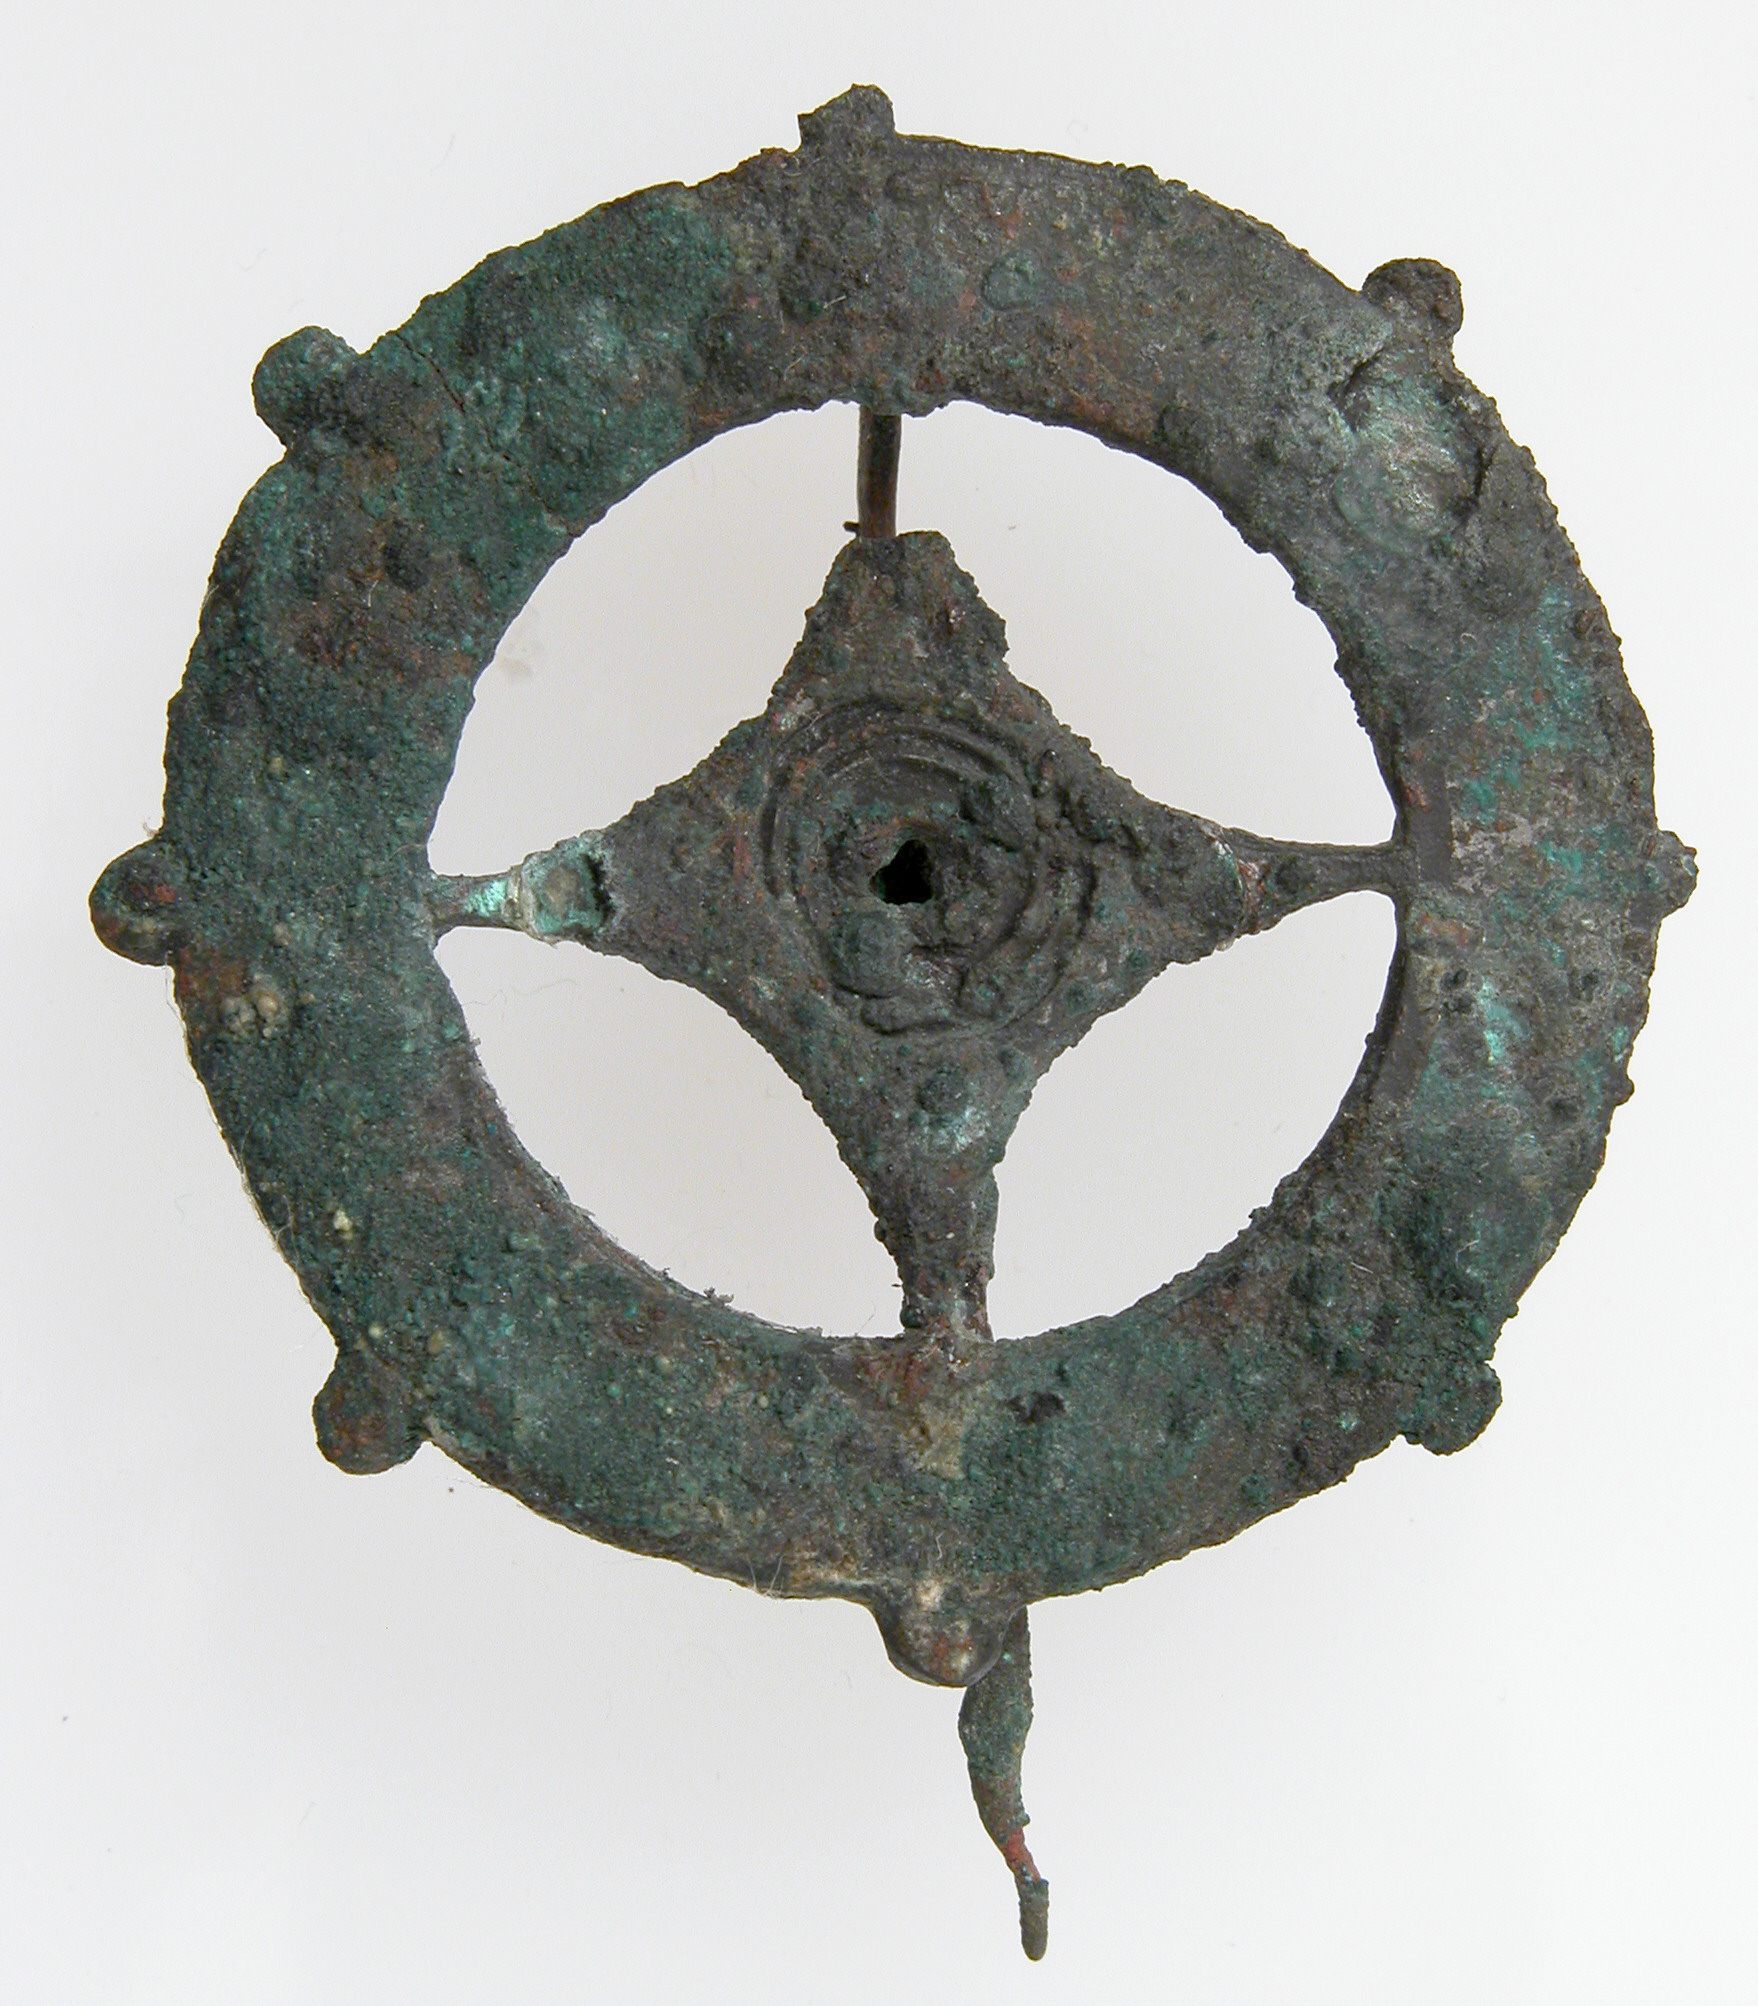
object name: brooch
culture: roman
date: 100-300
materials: bronze, enamel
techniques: enamel